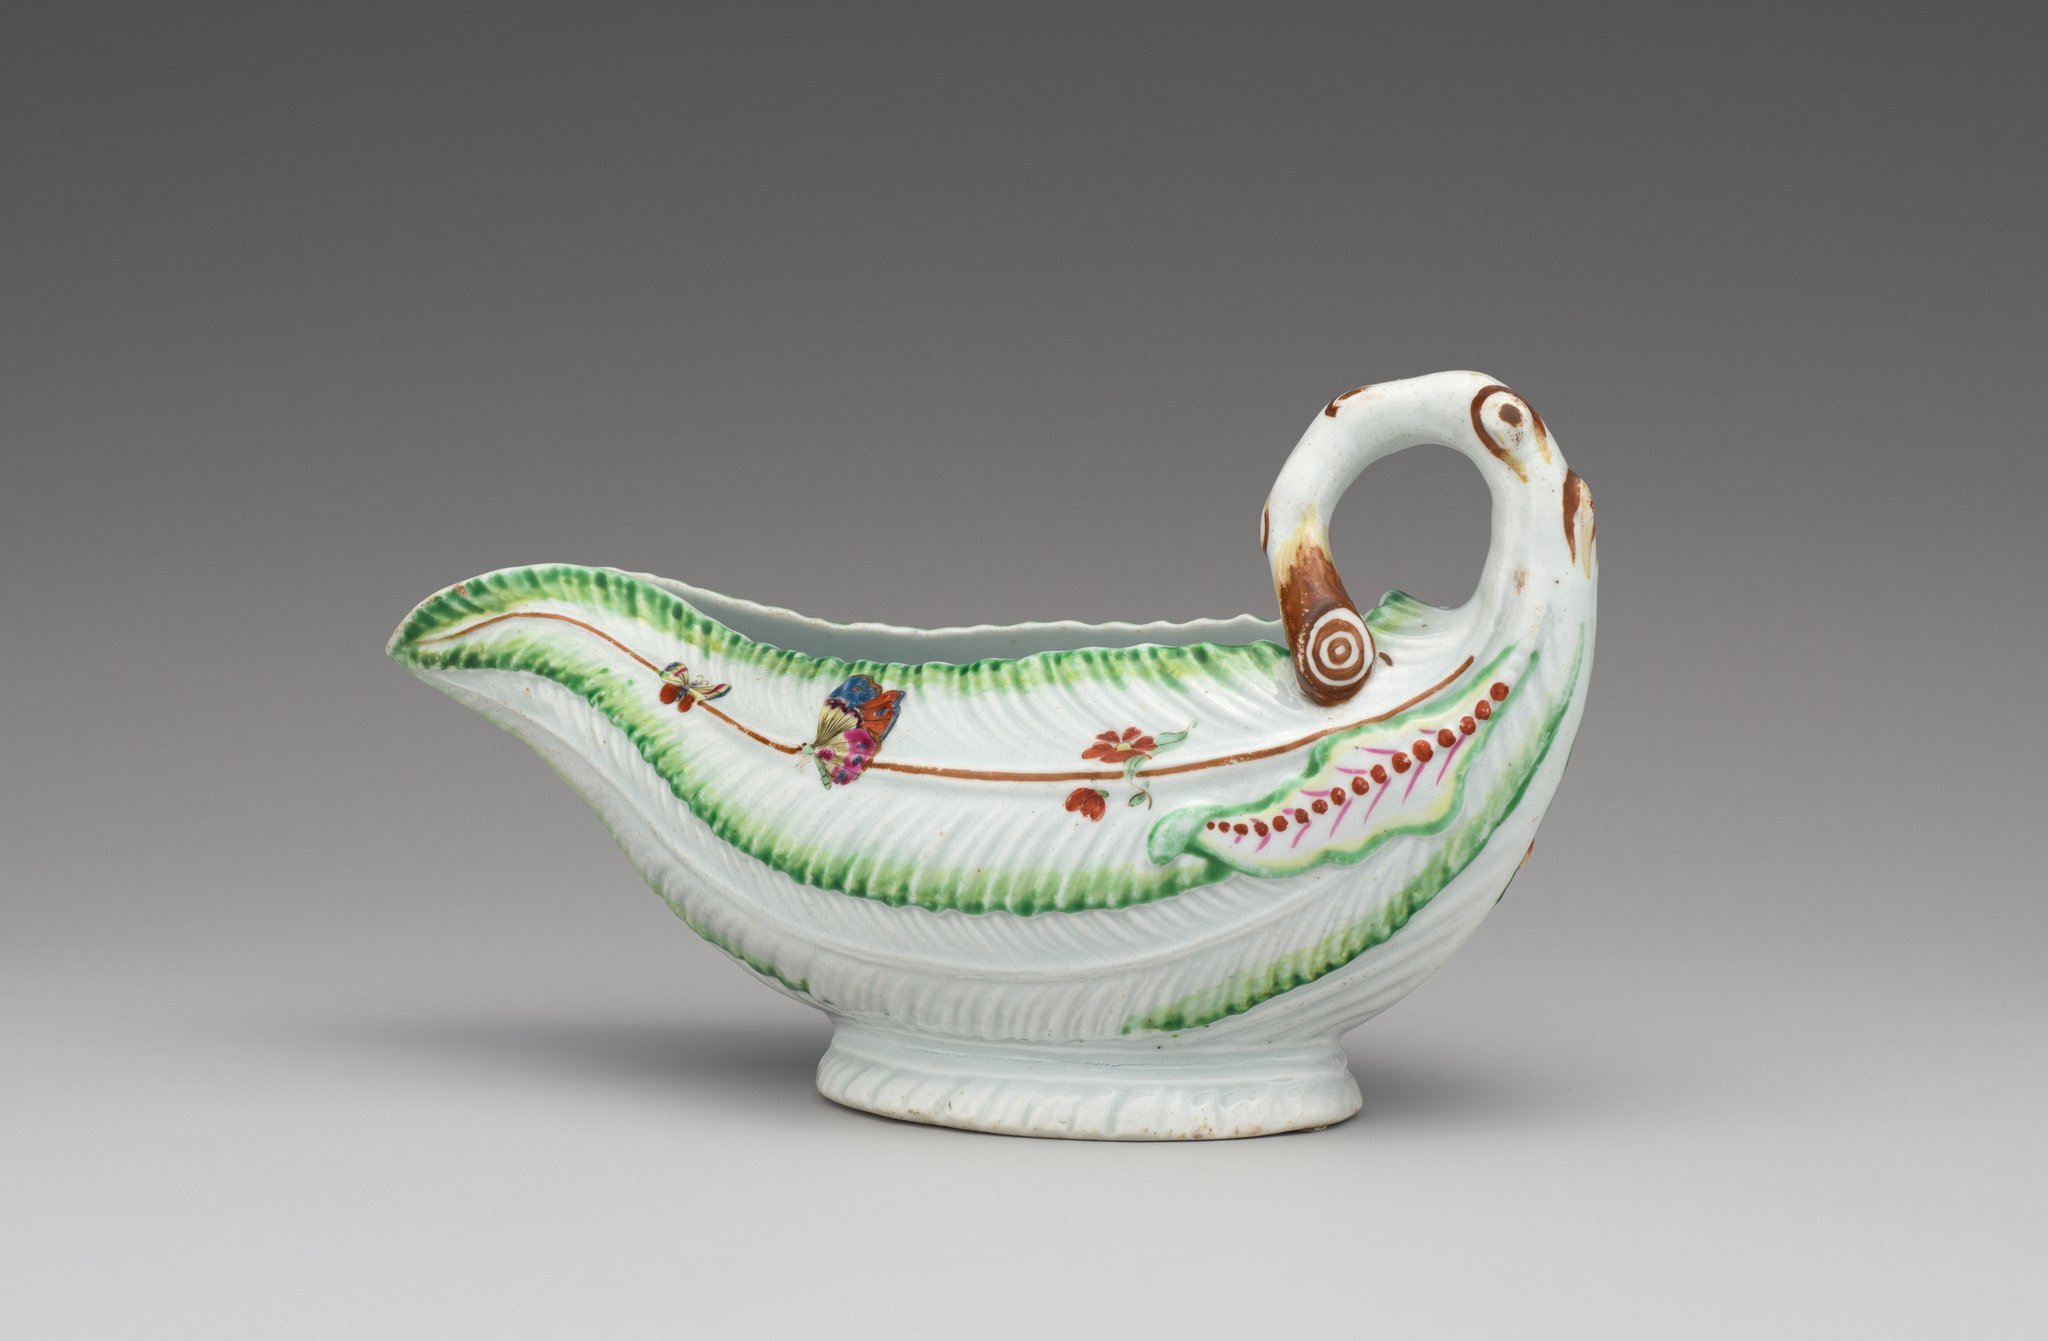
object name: sauceboat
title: Sauceboat (one of a pair)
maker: worcester factory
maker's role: factory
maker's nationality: british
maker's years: 1751-2008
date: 1755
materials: soft paste porcelain